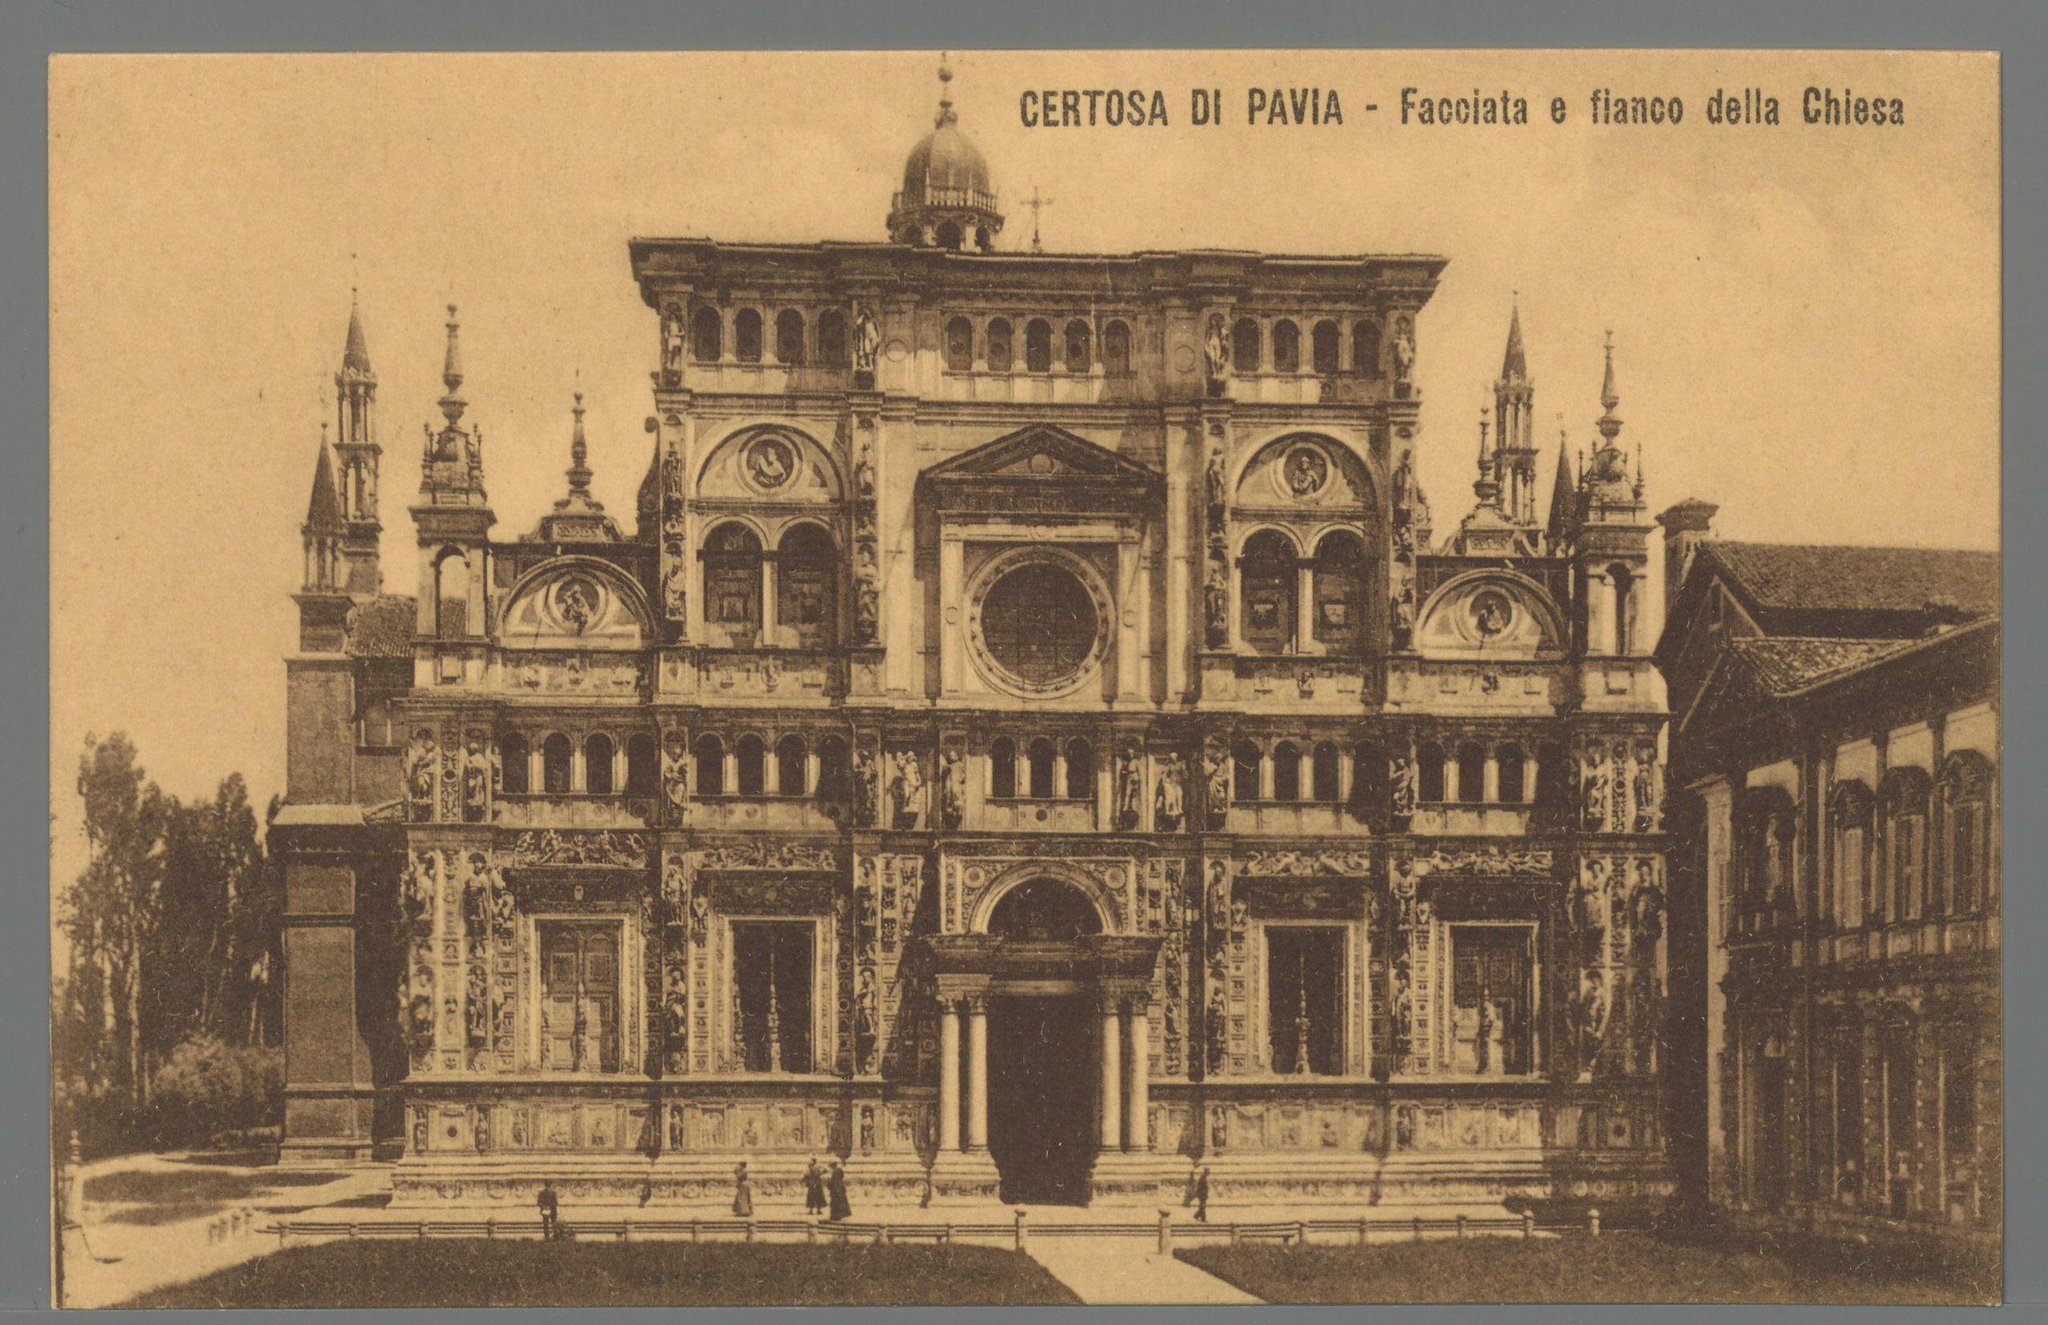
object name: ansichtkaart, prentbriefkaart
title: Certosa di Pavia. Facciata e fianco della Chiesa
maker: Anonymous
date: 1906-1920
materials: cardboard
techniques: photograph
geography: certosa di pavia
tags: abbey, monastery, convent ~ roman catholic church, abbey garden